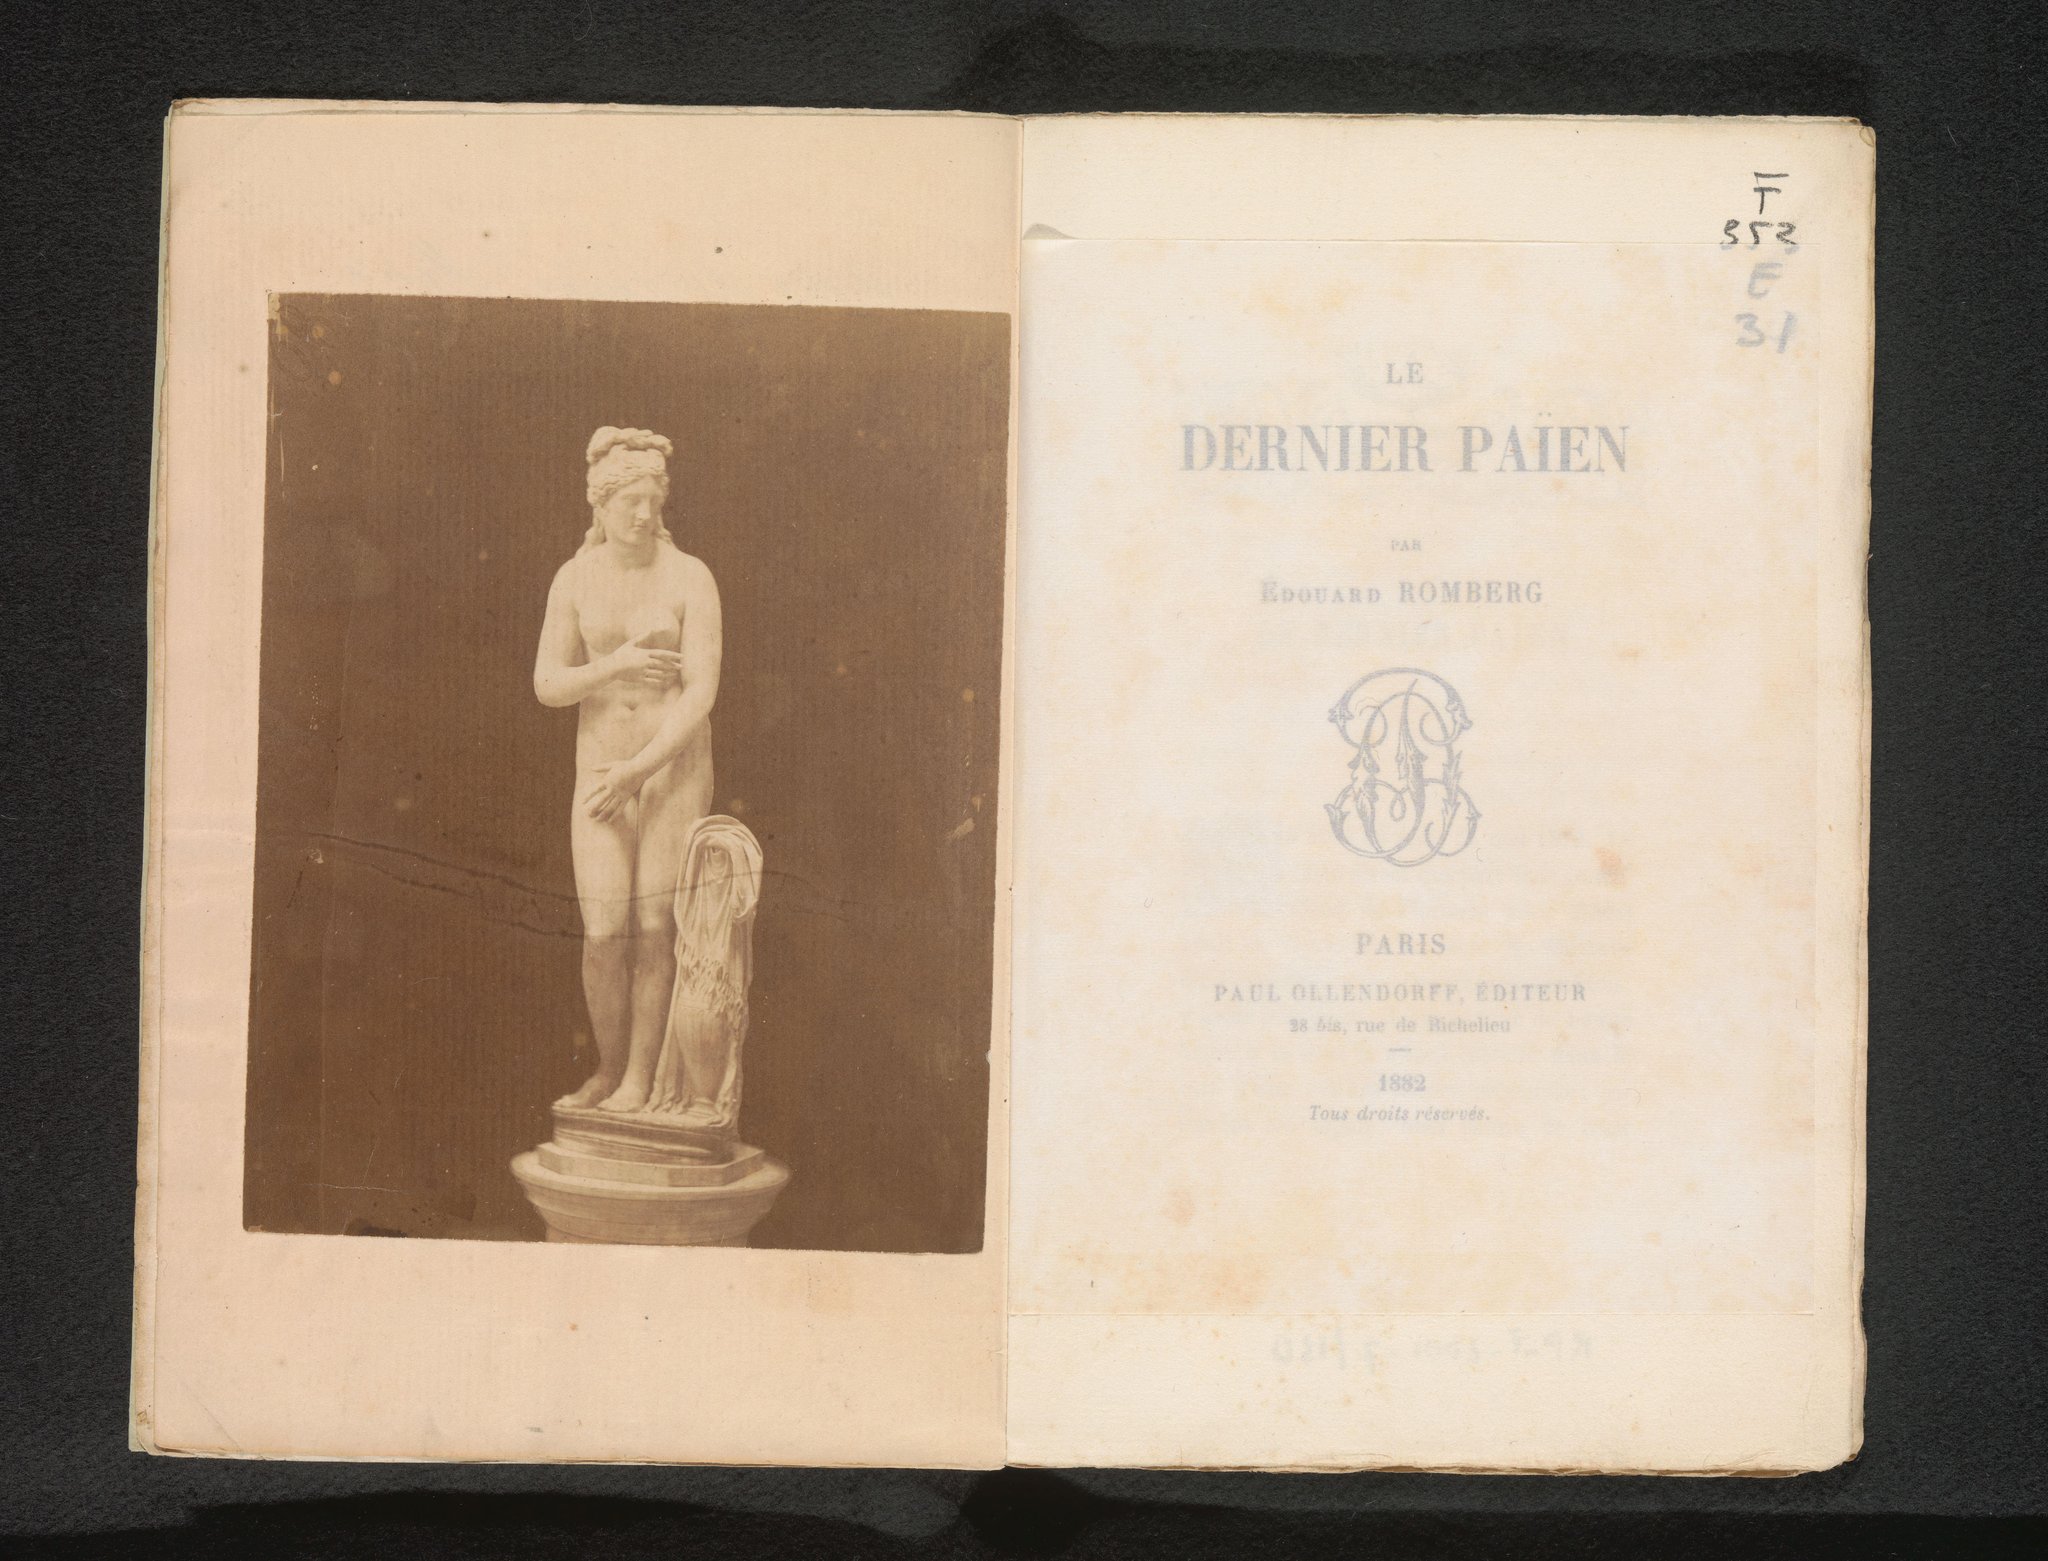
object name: photograph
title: Beeld van de Capitolijnse Venus in de Capitolijnse Musea te Rome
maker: Anonymous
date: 1872-1882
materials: photographic support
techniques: albumen print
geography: capitolijnse musea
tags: (story of) venus (aphrodite), sculpture